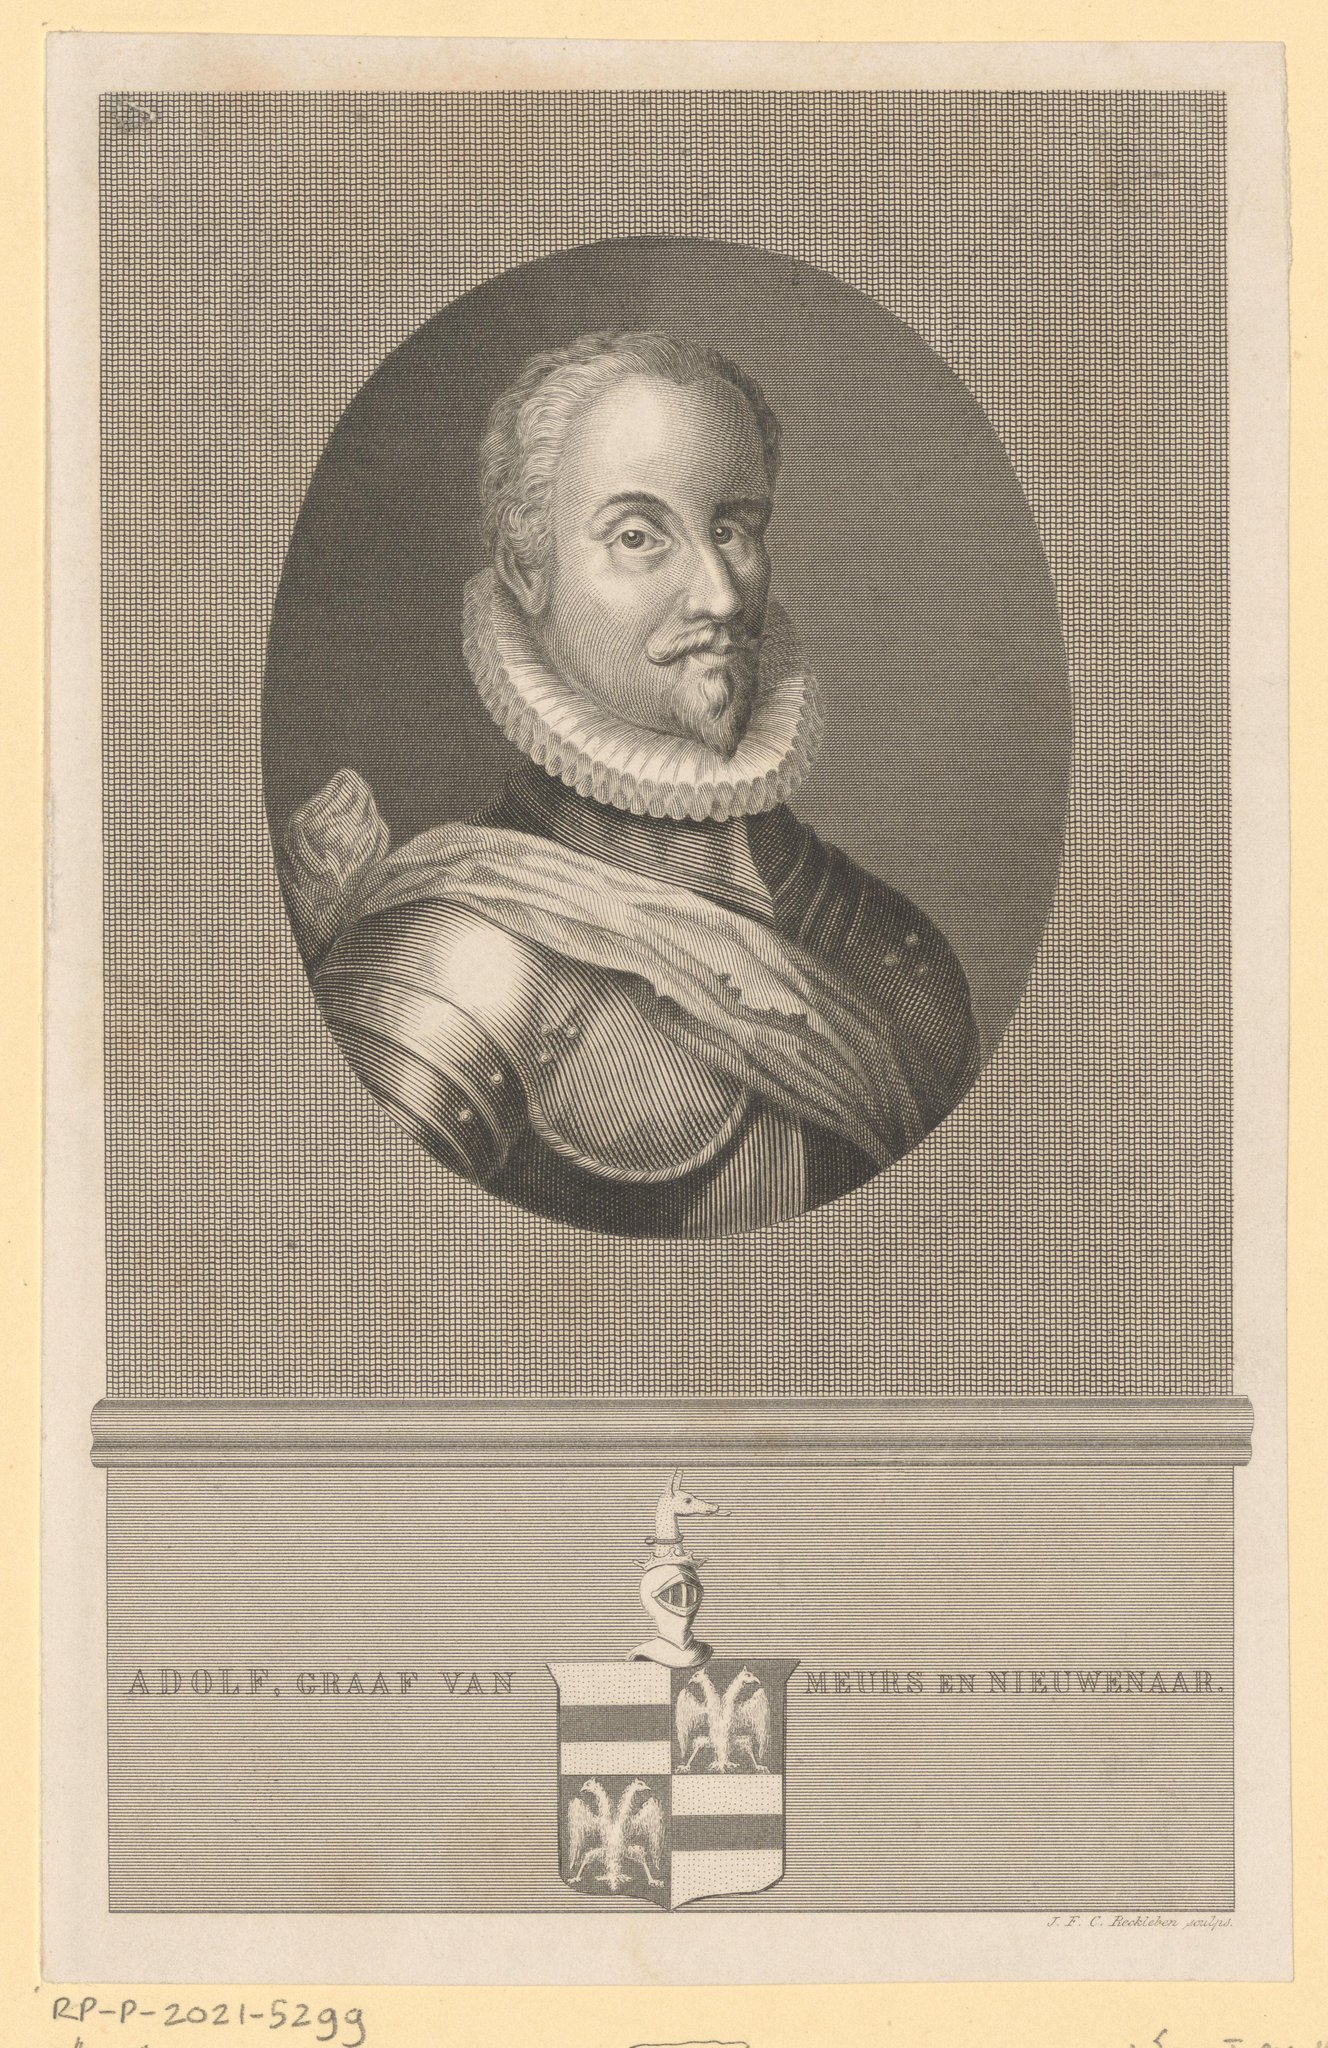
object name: print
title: Portret van Adolf graaf van Nieuwenaar en Meurs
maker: jan frederik christiaan reckleben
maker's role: print maker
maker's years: 1819-1879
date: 1857-1875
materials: paper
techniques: engraving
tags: historical persons, armorial bearing, heraldry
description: Prent waarschijnlijk uit: Arend, Johannes Pieter. Algemeene geschiedenis des vaderlands van de vroegste tijden tot op heden. Amsterdam: C. Schleijer en zoon, 1857, dl. 3.1.